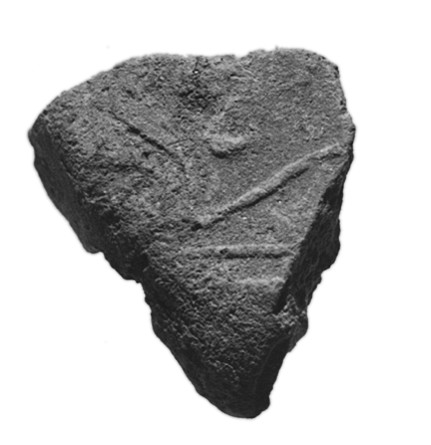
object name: sealing fragment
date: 2030-1640 BCE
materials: clay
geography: egypt